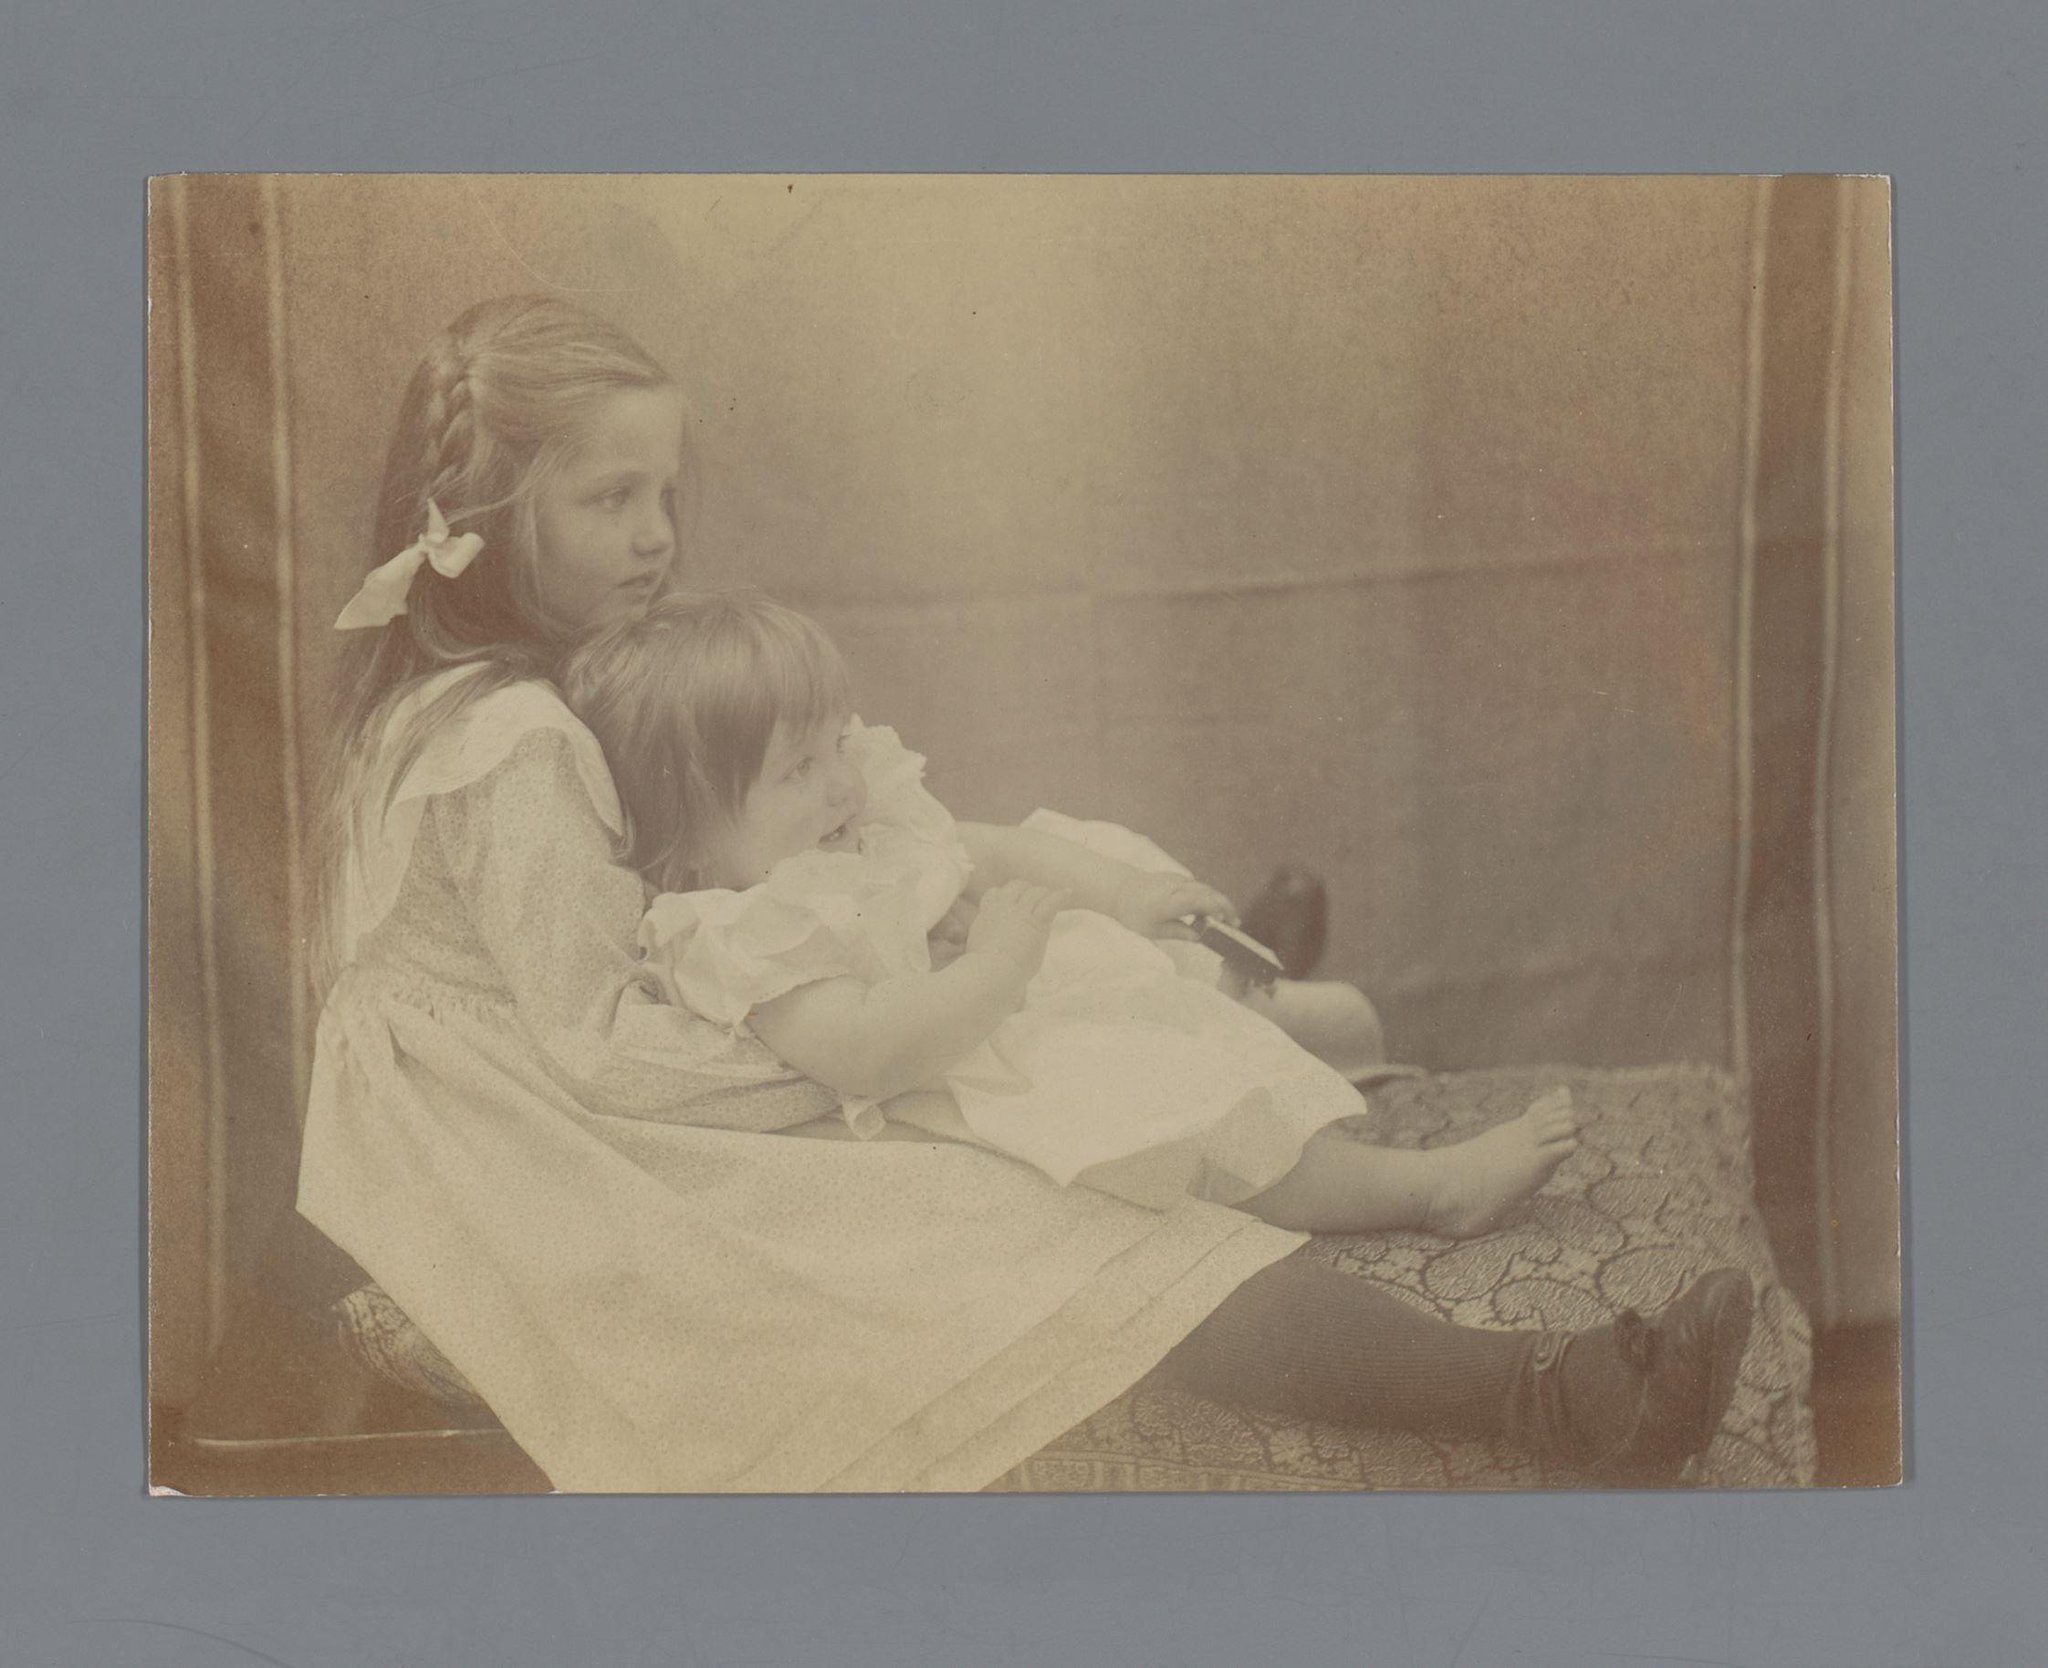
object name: photograph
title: Portret van twee onbekende kinderen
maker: johannes diderik van der waals (1873-1971)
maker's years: 1873-1971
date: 1900-1920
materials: photographic support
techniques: gelatin silver print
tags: historical persons - bb - woman, historical persons